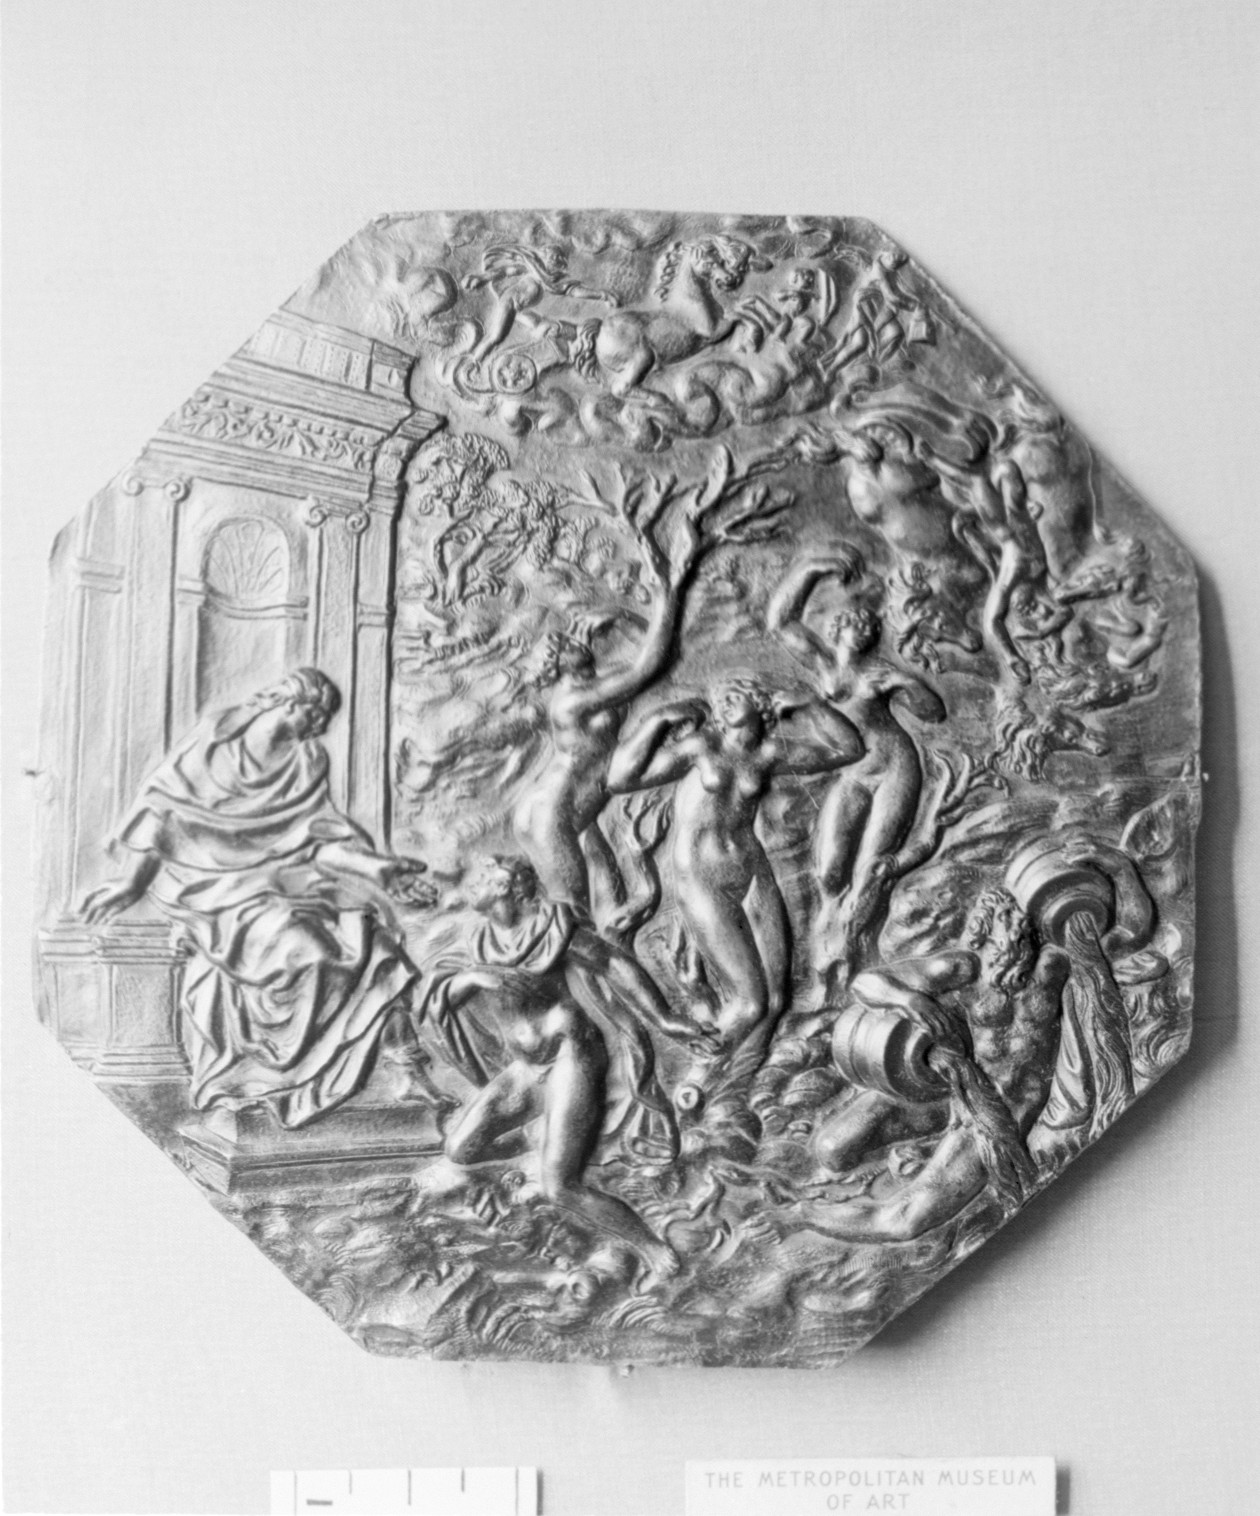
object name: plaquette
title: Story of Phaeton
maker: guglielmo della porta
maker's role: artist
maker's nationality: italian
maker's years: 1500-1577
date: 1567-1633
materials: bronze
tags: men,female nudes,horses,trees